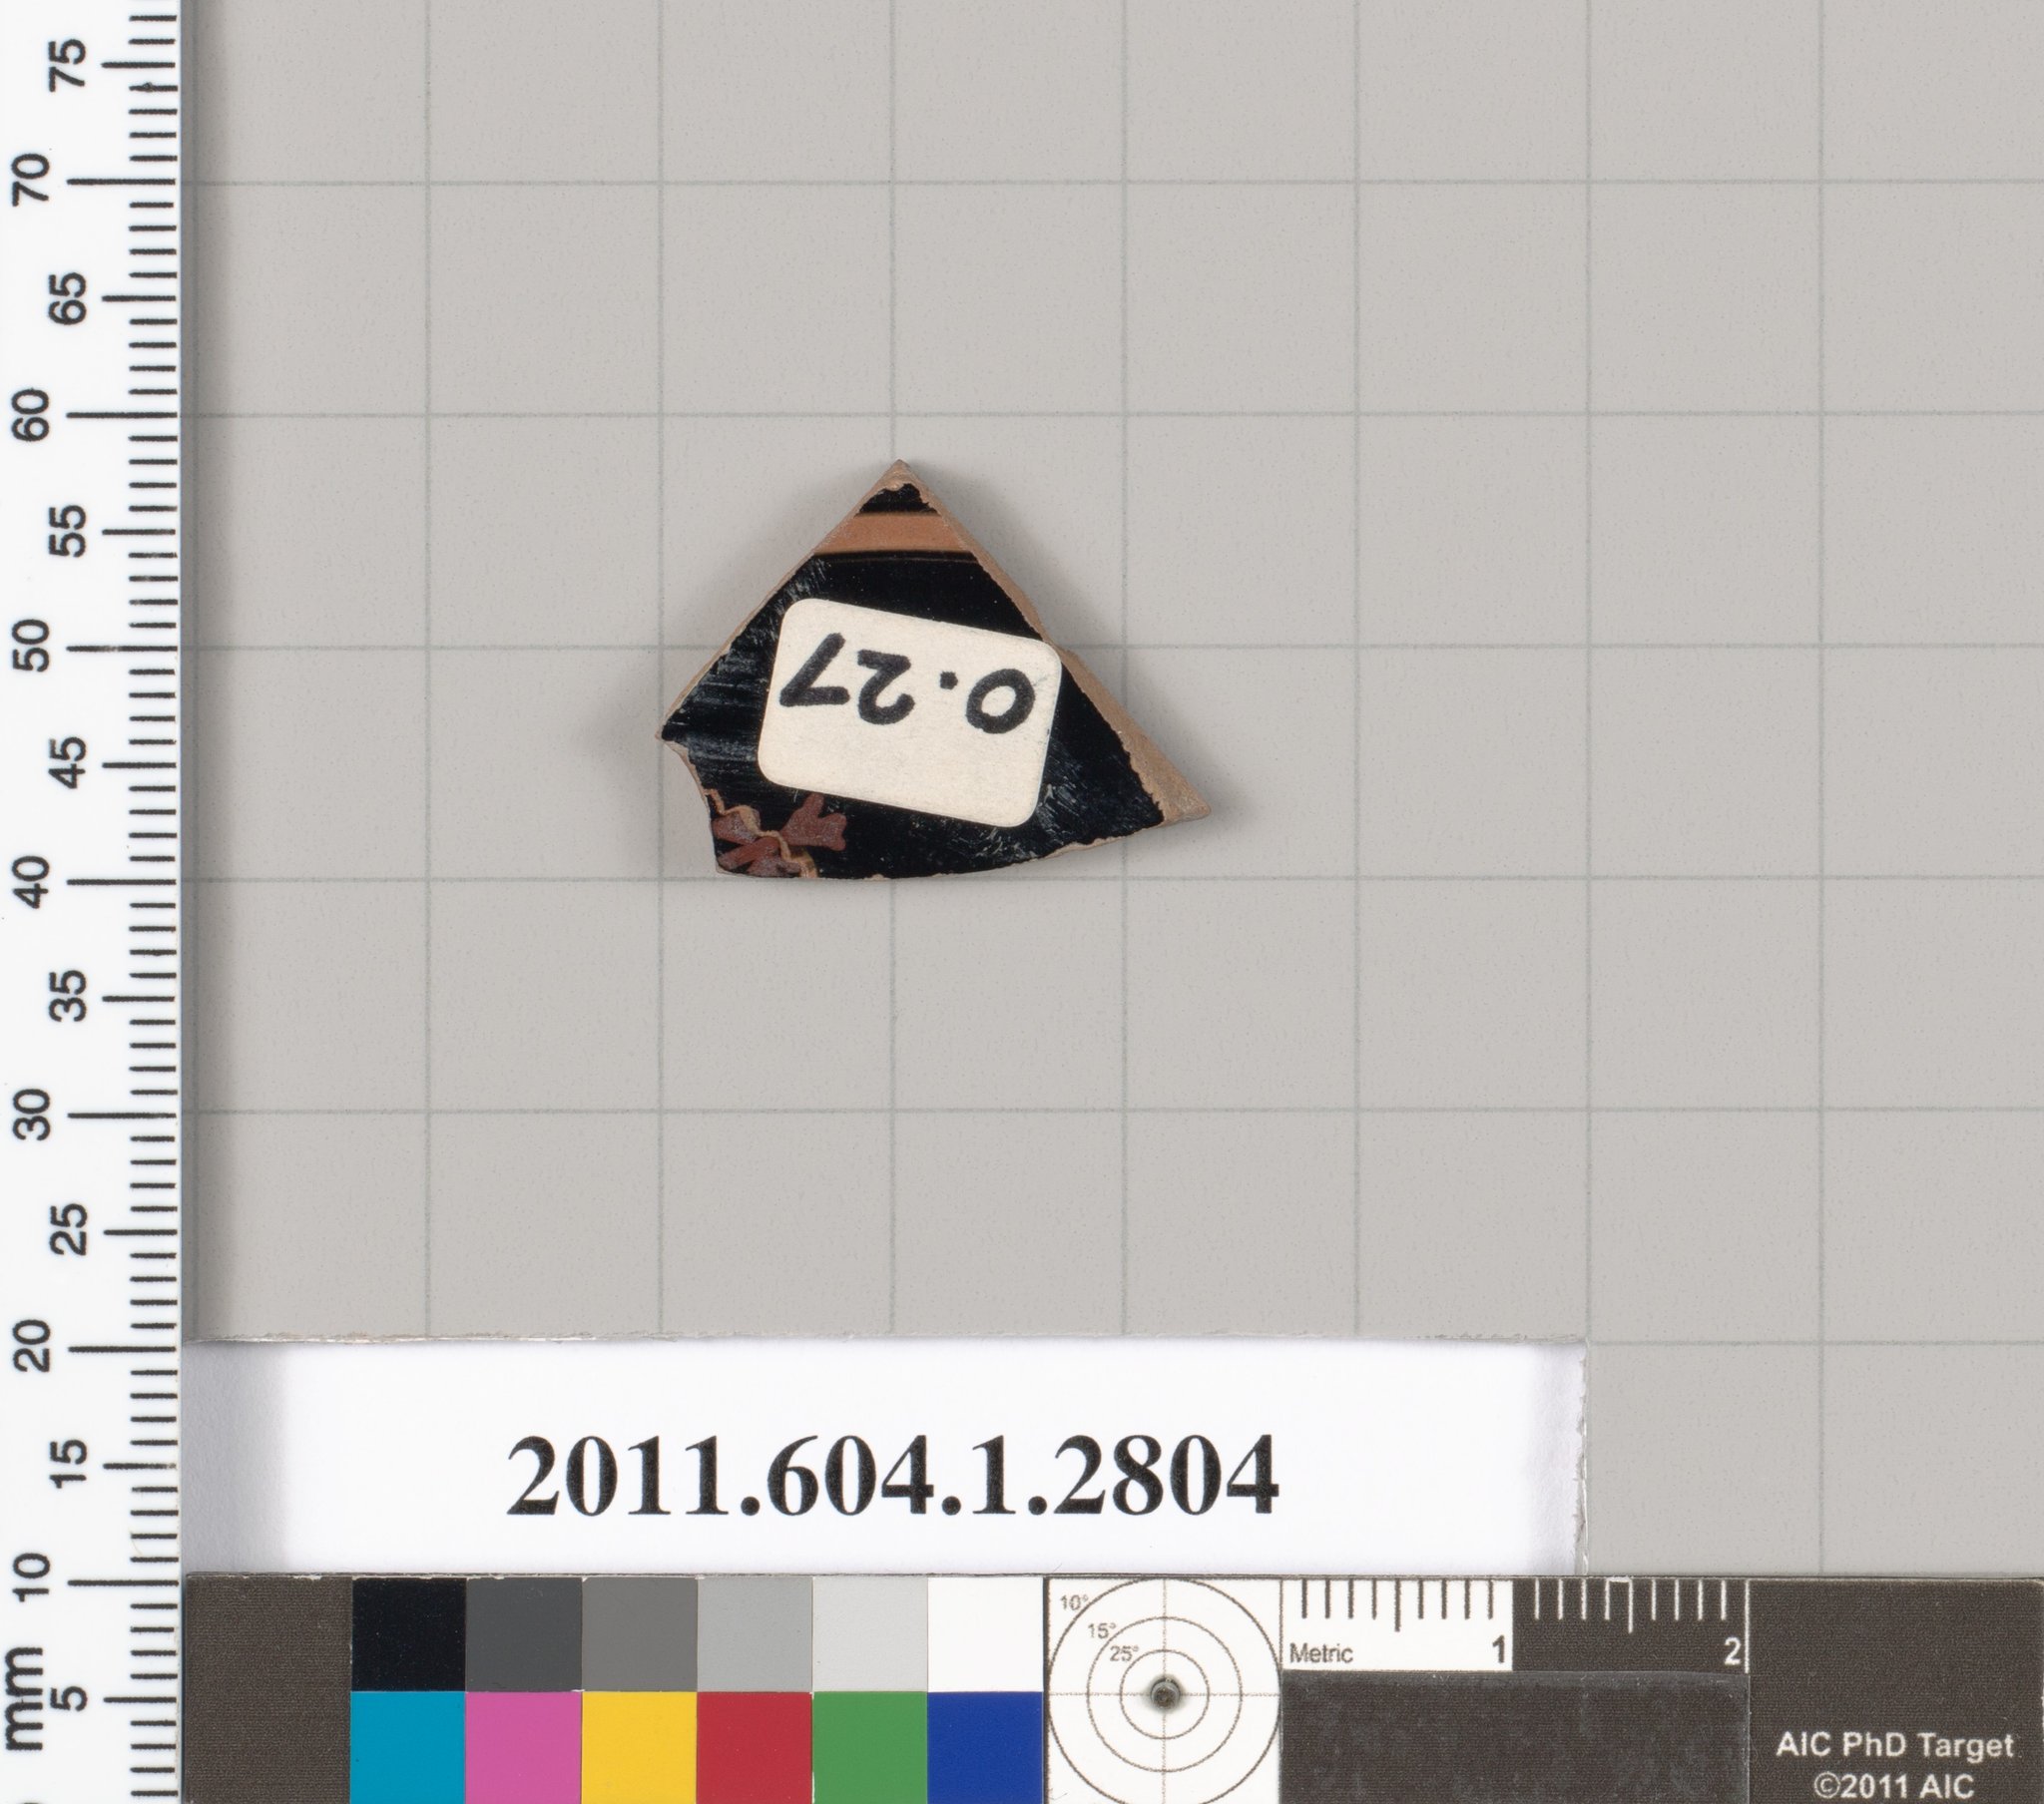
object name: kylix fragment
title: Terracotta fragment of a kylix (drinking cup)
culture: greek, attic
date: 520-500 BCE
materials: terracotta